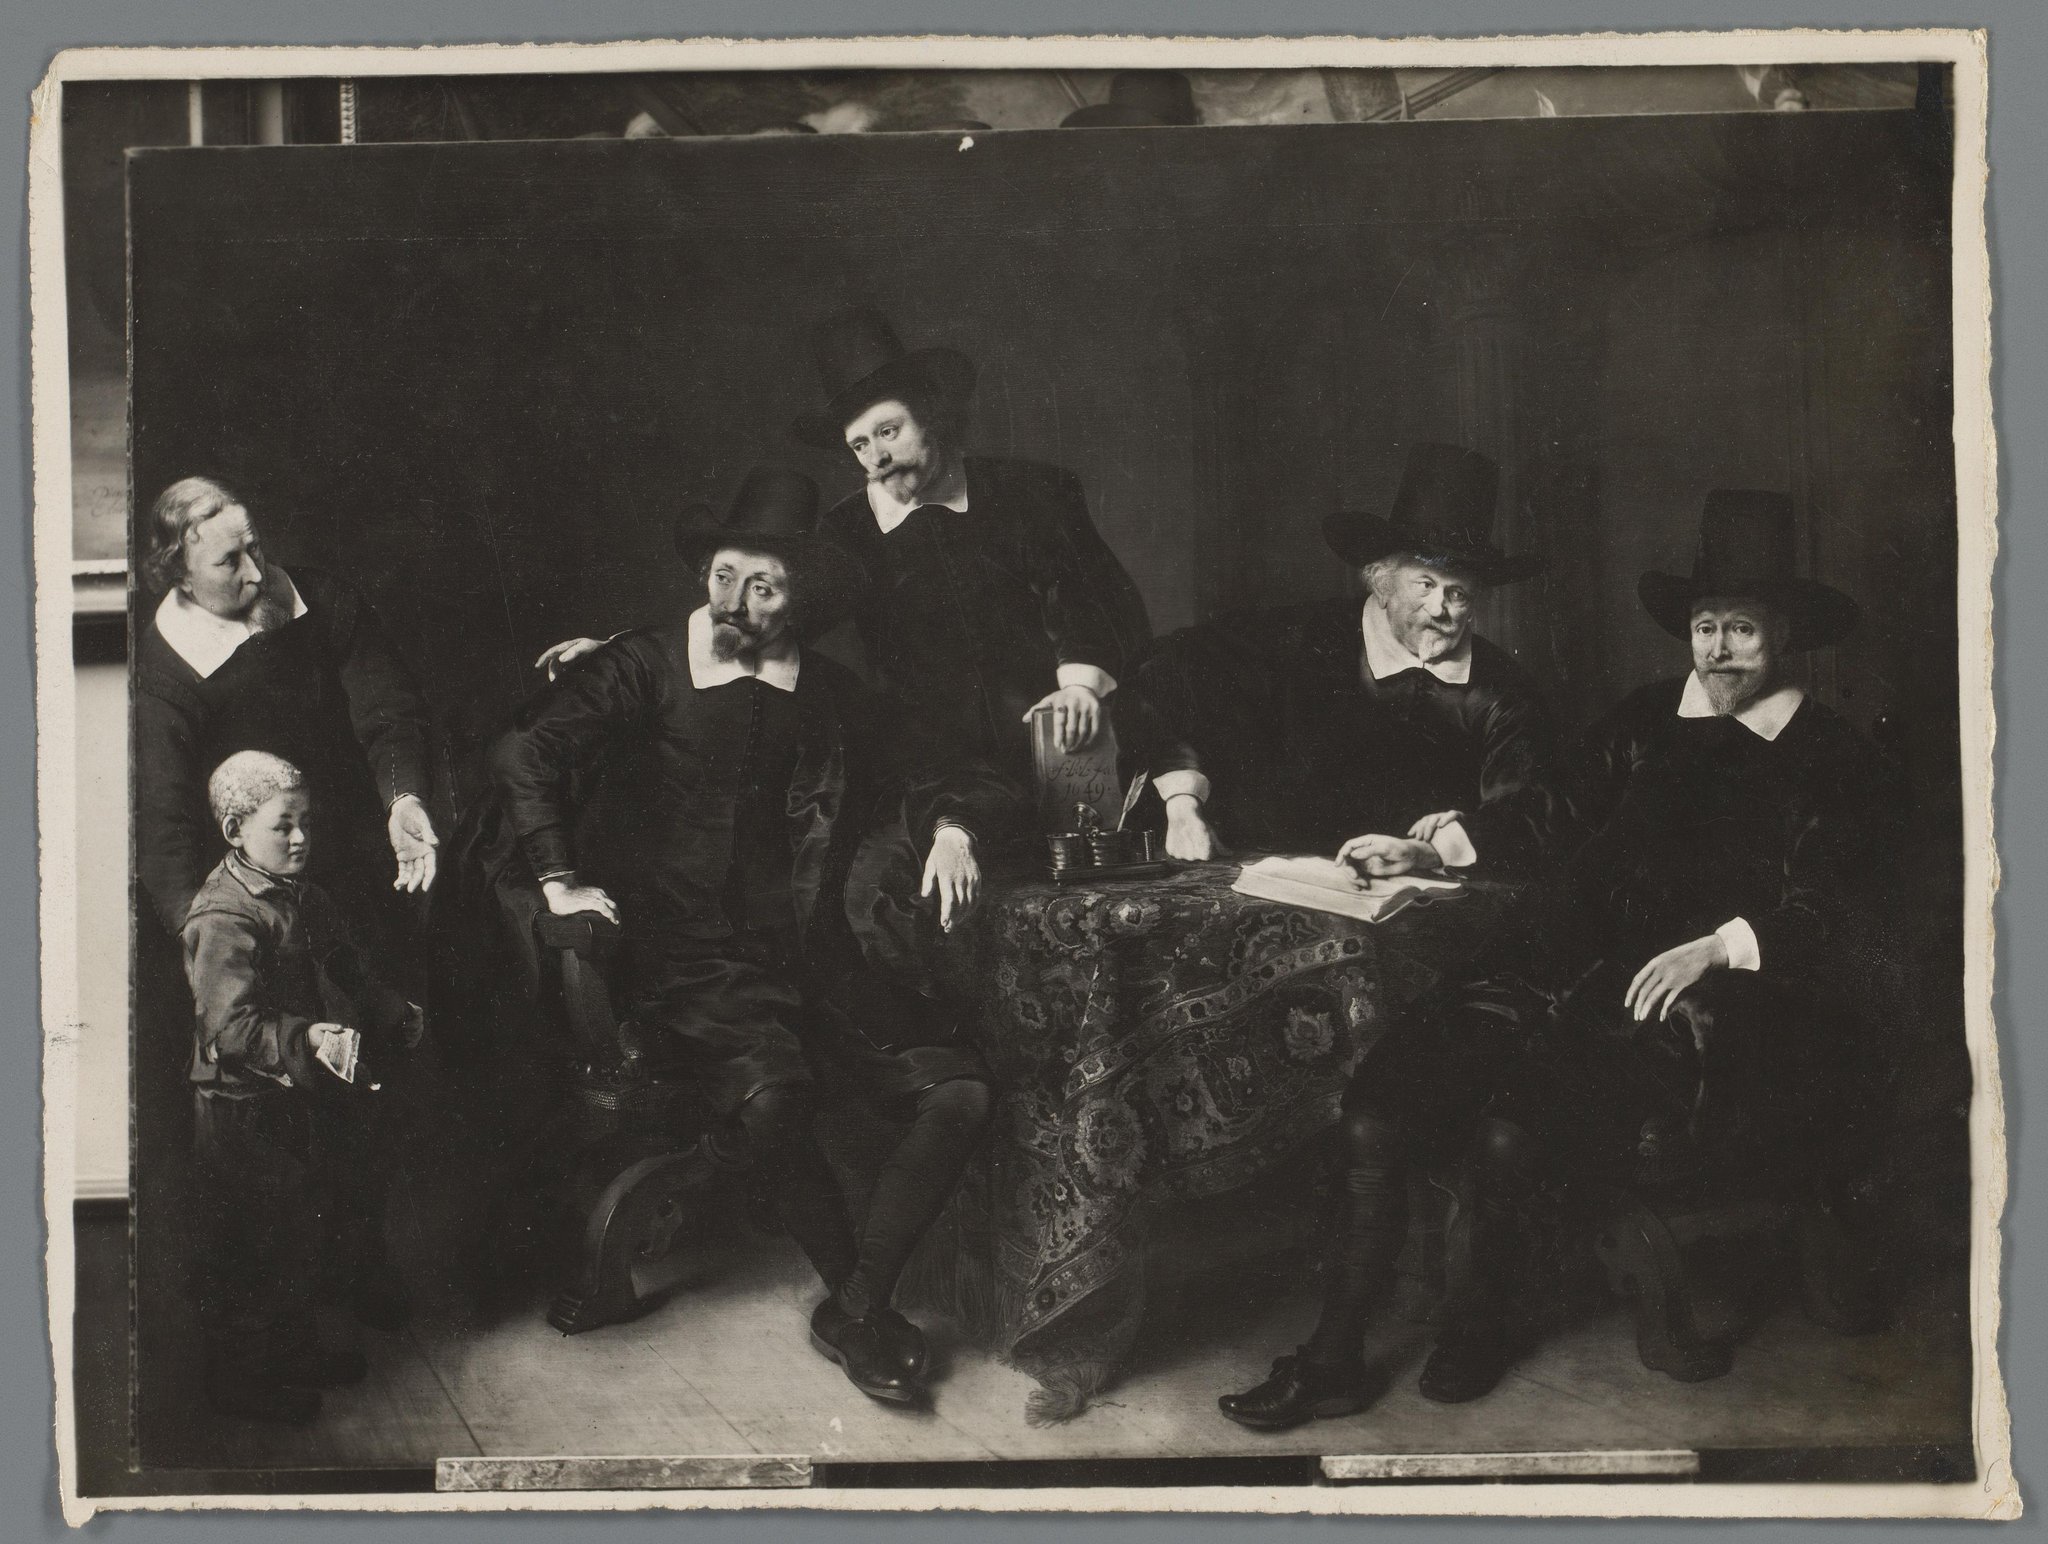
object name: reproduction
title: Fotoreproductie van schilderij De regenten van het Leprozenhuis, door Ferdinand Bol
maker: Anonymous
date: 1910-1990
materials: paper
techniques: gelatin silver print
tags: board, esp. governors, trustees, etc. (dutch: 'regenten')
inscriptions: number: ‘1440 .4’, number: ‘559.’